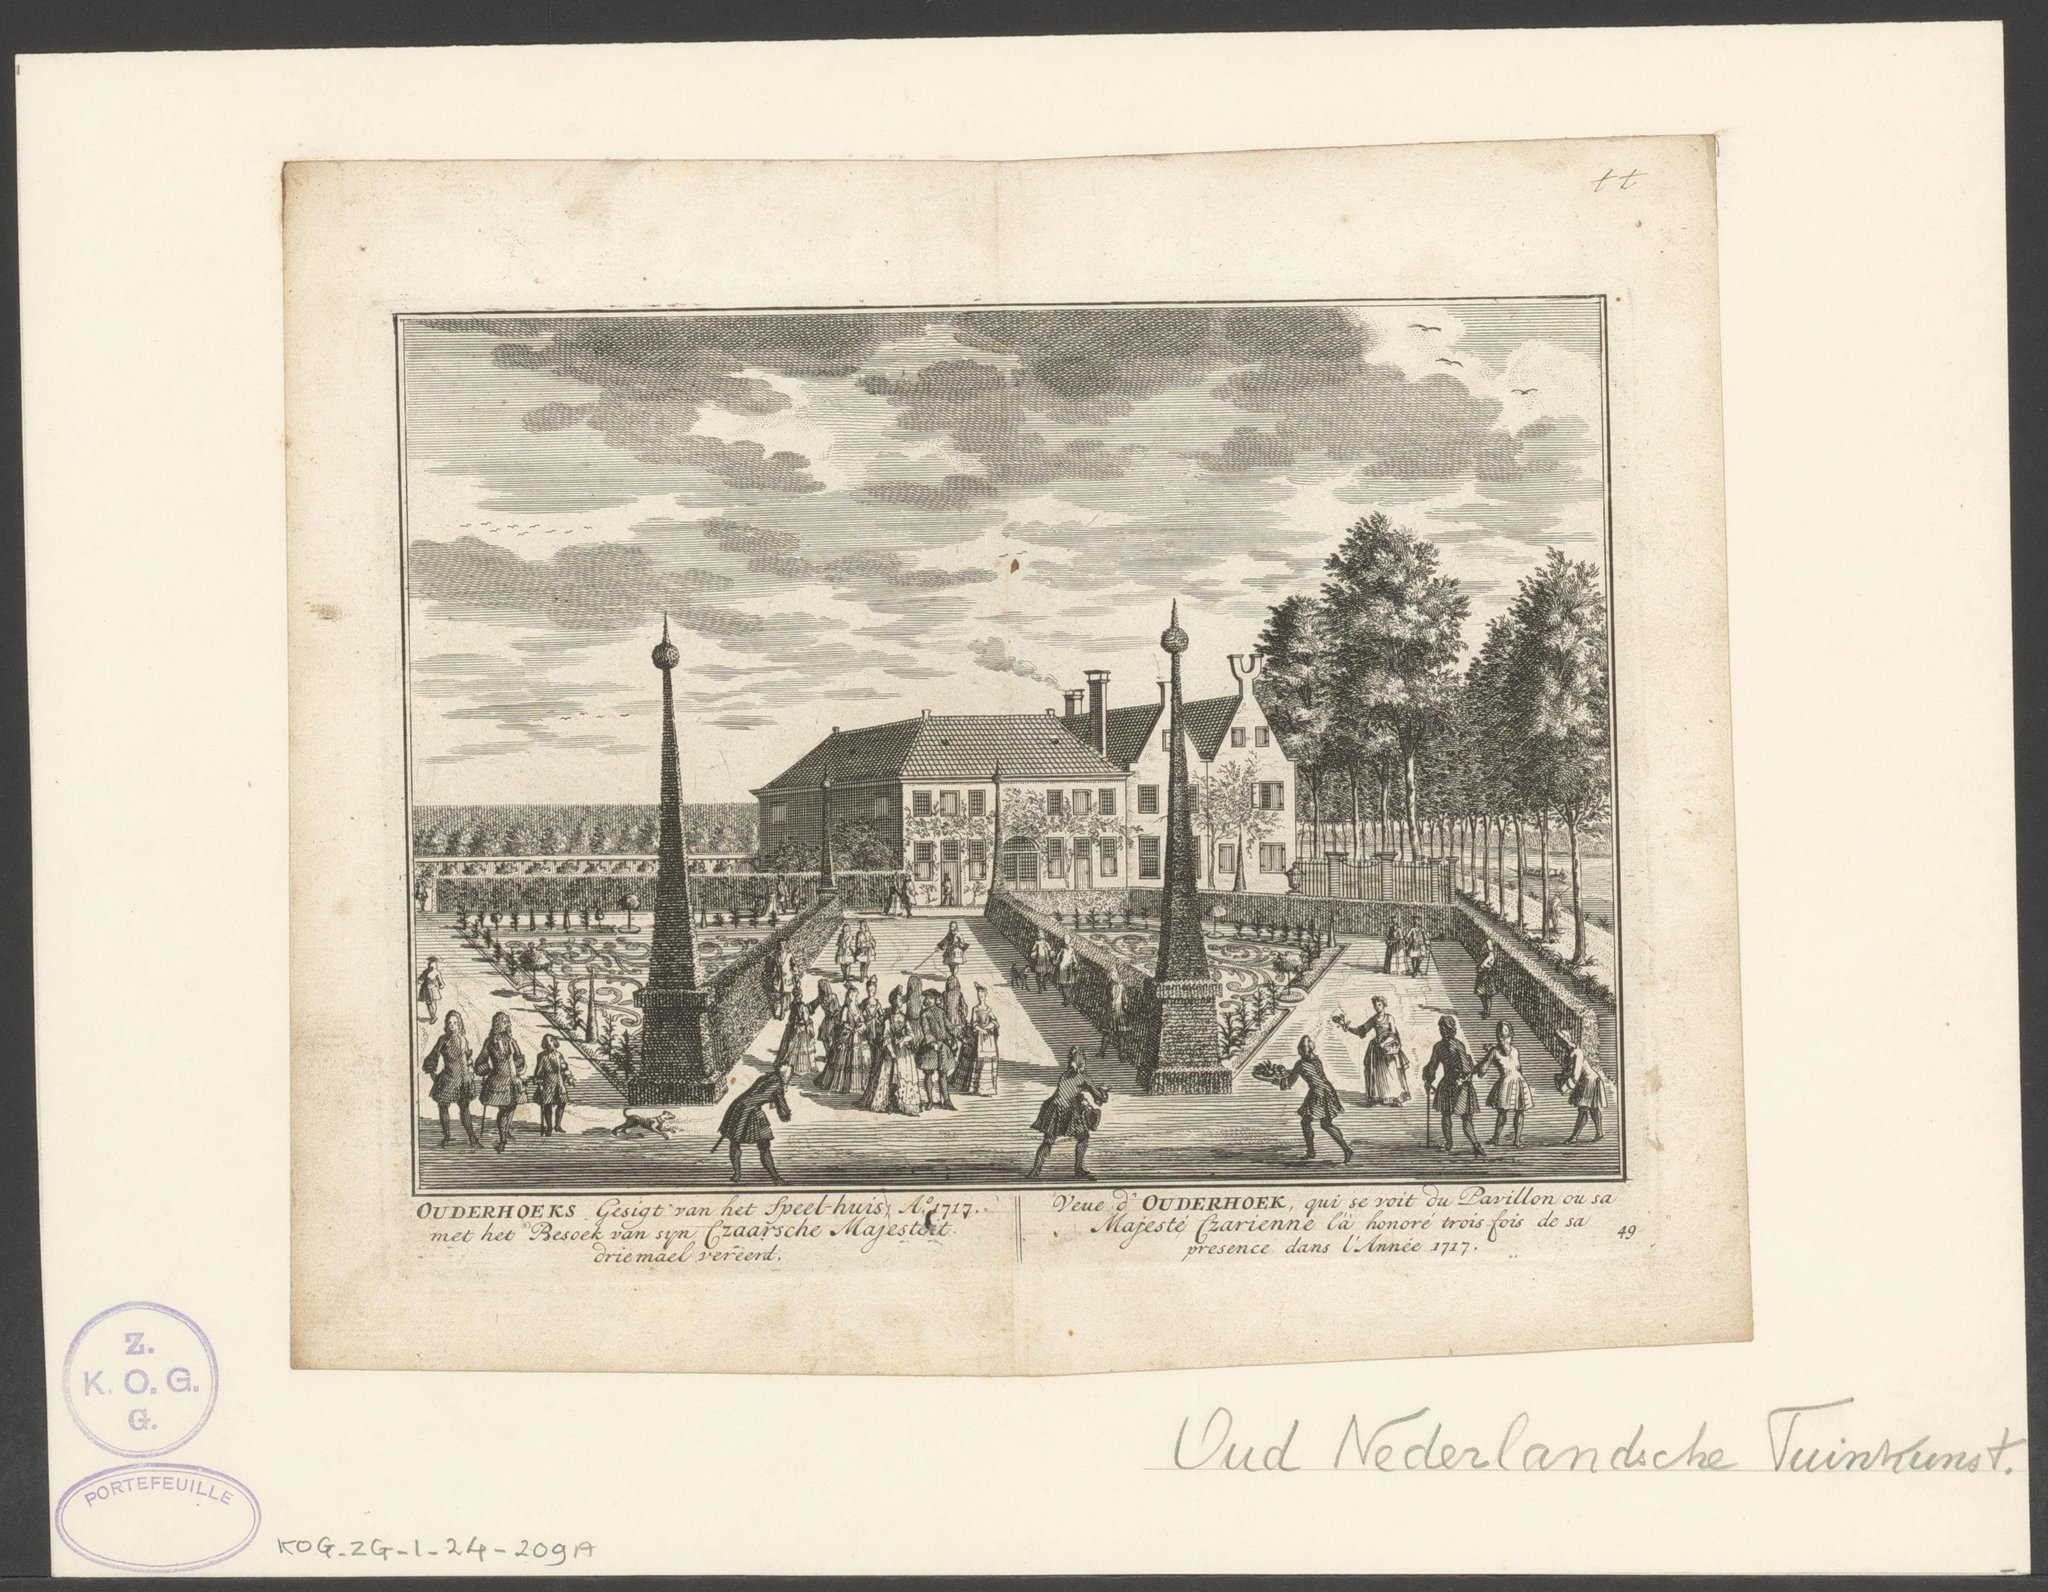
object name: print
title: Gezicht op de tuin en het huis Ouderhoek tijdens het bezoek van Tsaar Peter de Grote in 1717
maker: daniël stopendaal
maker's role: print maker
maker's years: 1672-1726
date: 1719-1790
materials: paper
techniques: engraving, etching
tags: country-house, vecht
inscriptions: stamp, collector's mark: Lugt 1641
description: Prent voor het eerst gebruikt in: Leth, Andries de. De zegepraalende Vecht, vertoonende verscheidene gesichten van lustplaatsen, heeren huysen en dorpen, beginnende van Uitrecht en met Muyden besluytende (...). Amsterdam: Weduwe Nicolaus Visscher, 1719. Prent mogelijk uit: Brouërius van Nidek, Matthaeus. De Vechtstroom, van Utrecht tot Muiden (...). Amsterdam: H. Gartman, W. Vermandel en J.W. Smit, 1790.